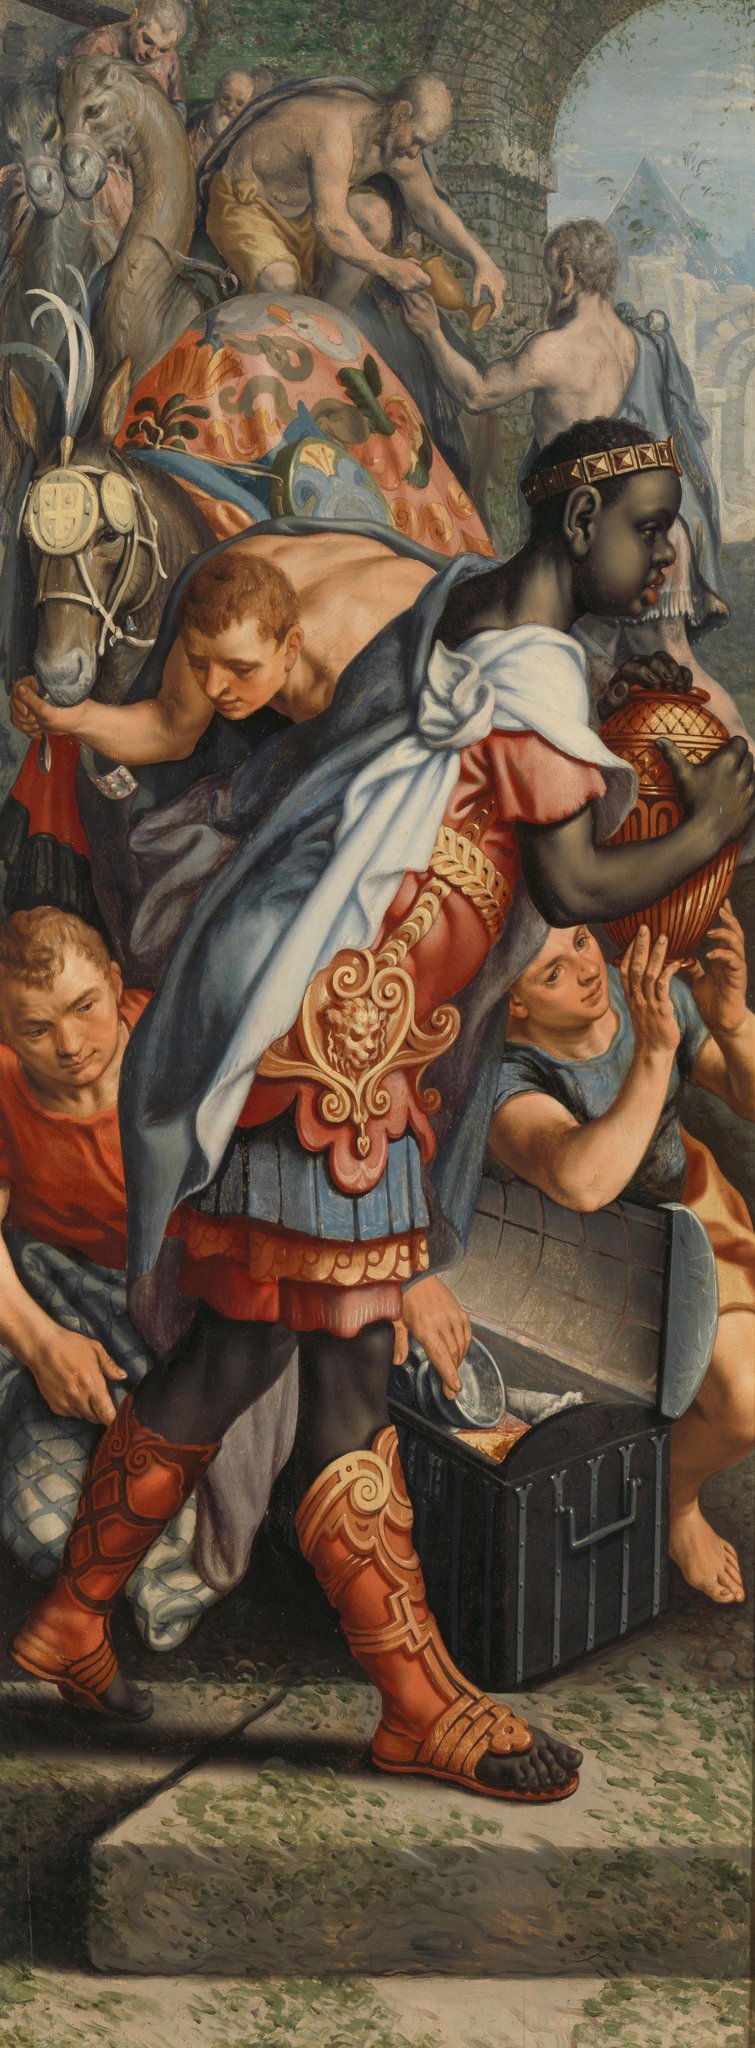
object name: painting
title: Wing of an Altarpiece with Adoration of the Magi, on the reverse is Presentation in the Temple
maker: pieter aertsen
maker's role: draughtsman, painter, print maker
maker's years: 1508-1575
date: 1560-1565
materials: oil, paint, panel, wood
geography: amsterdam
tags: adoration of the kings: the wise men present their gifts to the christ-child (gold, frankincense and myrrh), presentation of the christ-child in the temple, usually simeon (and anna) present (luke 2:22-39)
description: Pieter Aertsen (1509 - 1575). Left panel of a triptych depicting the adoration of the Magi; on the reverse the presentation in the temple, c. 1560. Centre panel of a triptych depicting the adoration of the Magi, c. 1560 Although these two panels are not of equal length, they once formed part of the same work. The inside of this triptych portrays the adoration of the Magi, but in a highly unusual composition: each section of the triptych features one of the kings. The narrow panel, which shows the black king, was acquired by the museum in 1900 as a donation. The centre panel did not come into the possession of the Rijksmuseum until after the war. The right-hand panel, with the youngest king, has never been recovered. (side panel) From a church in Delft. Until 1860 in the City Hall of Delft. Bequest of Jonkheer J.P.Six (Amsterdam), 1900, on loan from 1885. (centre) Deutzenhofje, Amsterdam. On loan, from the P. & N. de Boer Stichting, Amsterdam, 1960.